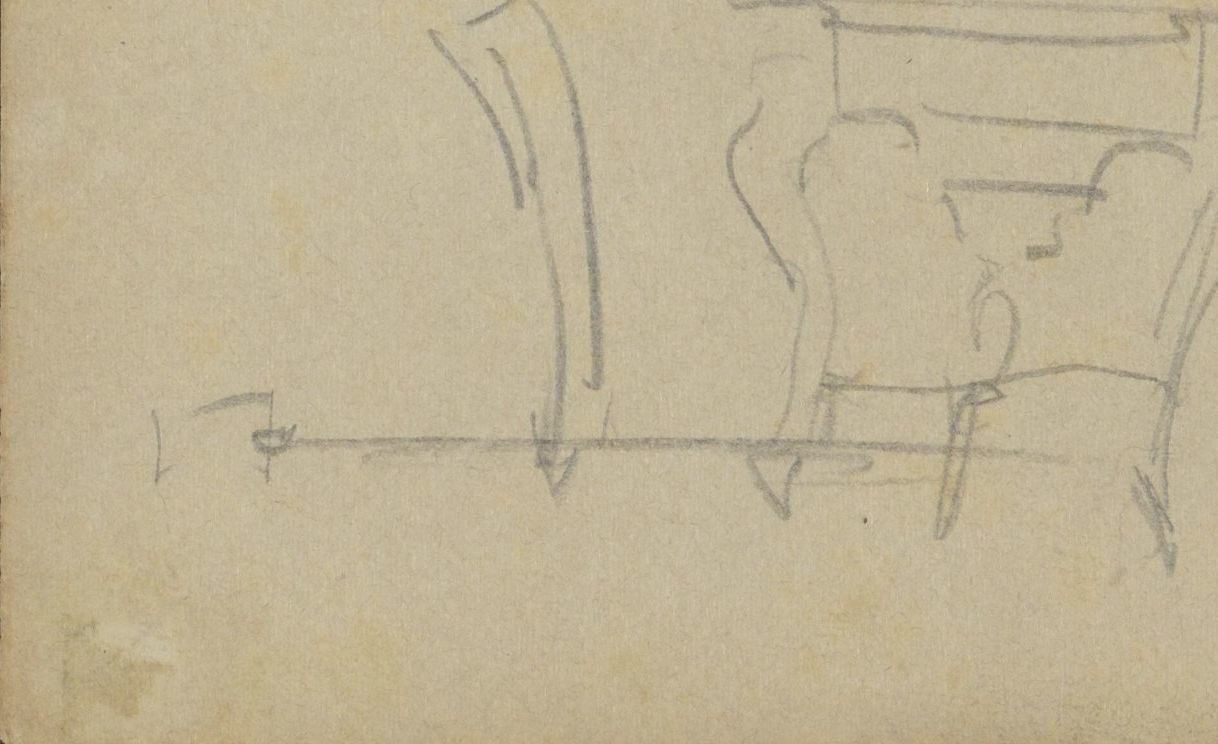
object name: drawing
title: Studie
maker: george hendrik breitner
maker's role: draughtsman, painter, print maker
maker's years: 1857-1923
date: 1887-1891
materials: paper, pencil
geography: gelderland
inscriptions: collector's mark: Lugt 2228